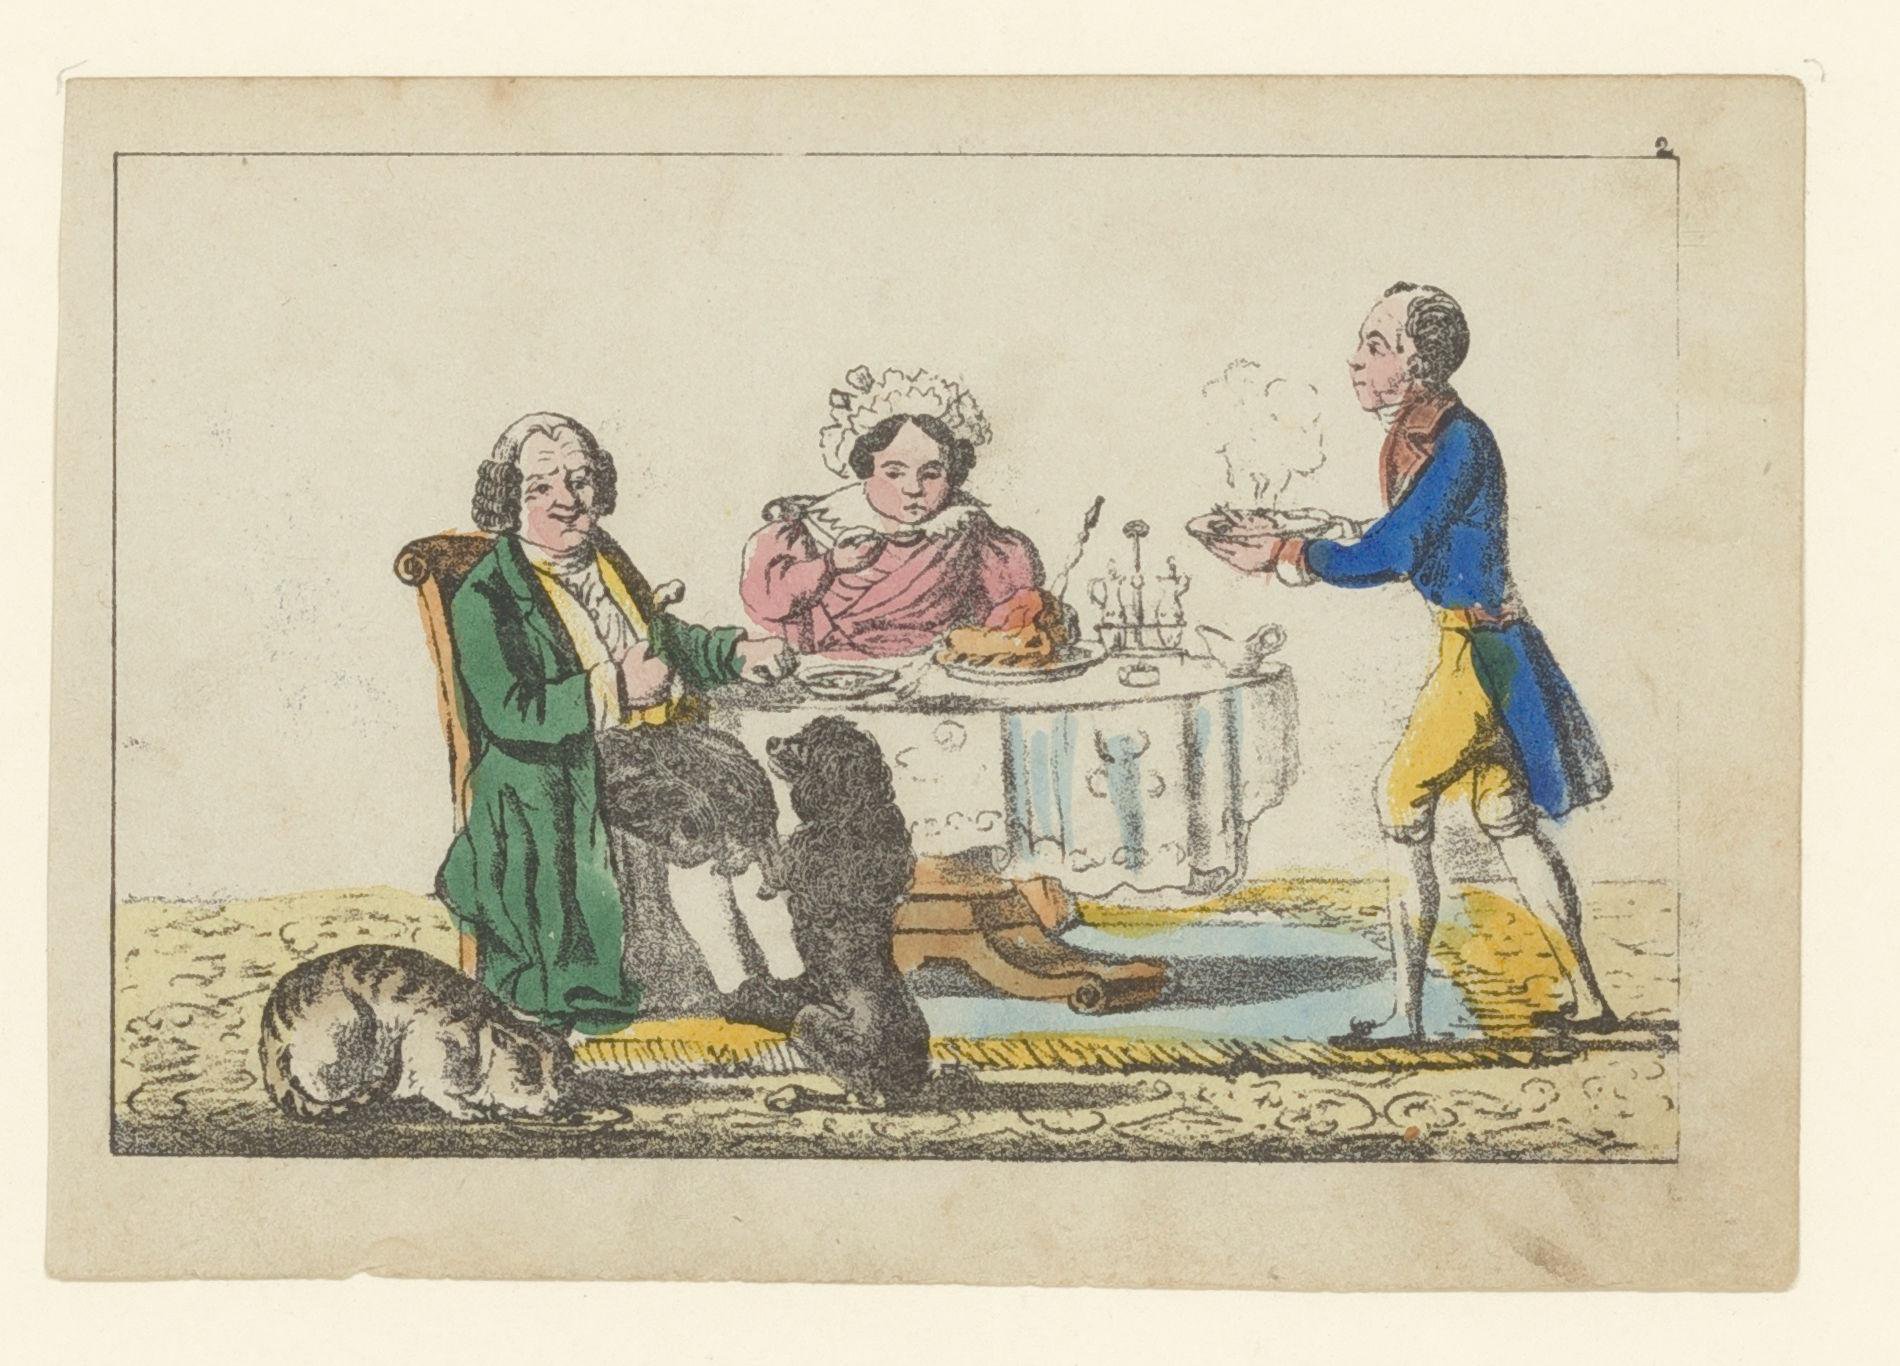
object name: print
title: Kardoes en Muizenschik onder de tafel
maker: Anonymous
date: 1841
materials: paper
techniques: hand coloring, lithograph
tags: cat, evening meal, dinner, supper, dog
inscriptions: stamp, collector's mark: Lugt 1641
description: Rechtsboven genummerd: 2. Onderwerpsrubrieken binnen de Atlas Zeden en Gewoonten: Zeden en Gewoonten in Engeren Zin, Des menschen beging, midden en einde, Kinderleven – Kinderspel en Kinderprenten.